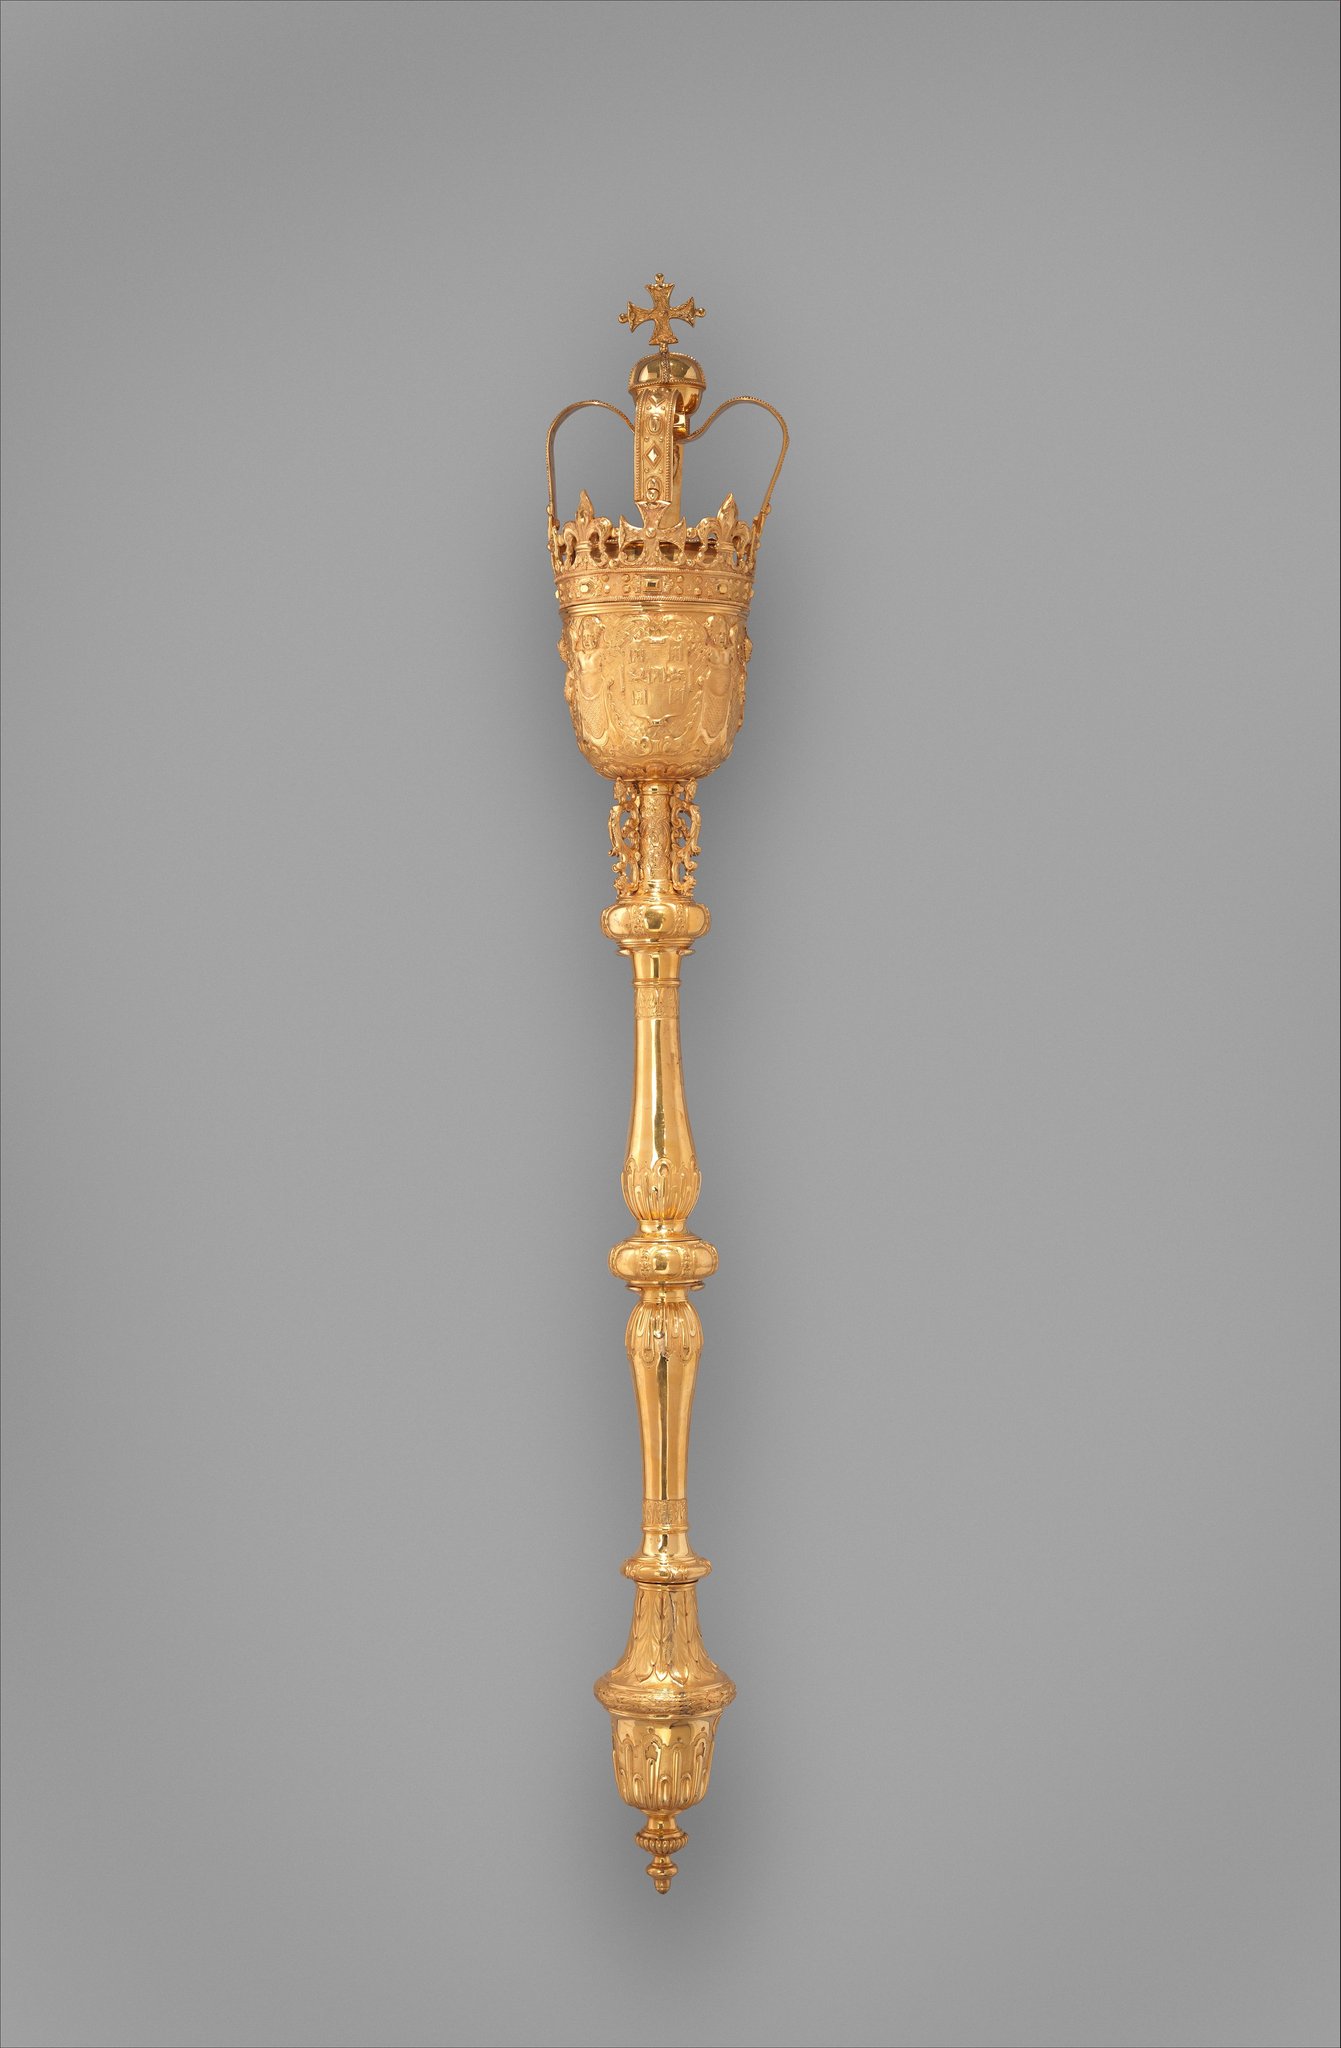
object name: mace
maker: benjamin pyne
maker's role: artist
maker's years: 1693-1727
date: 1801-1900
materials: copper, gilt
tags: cross